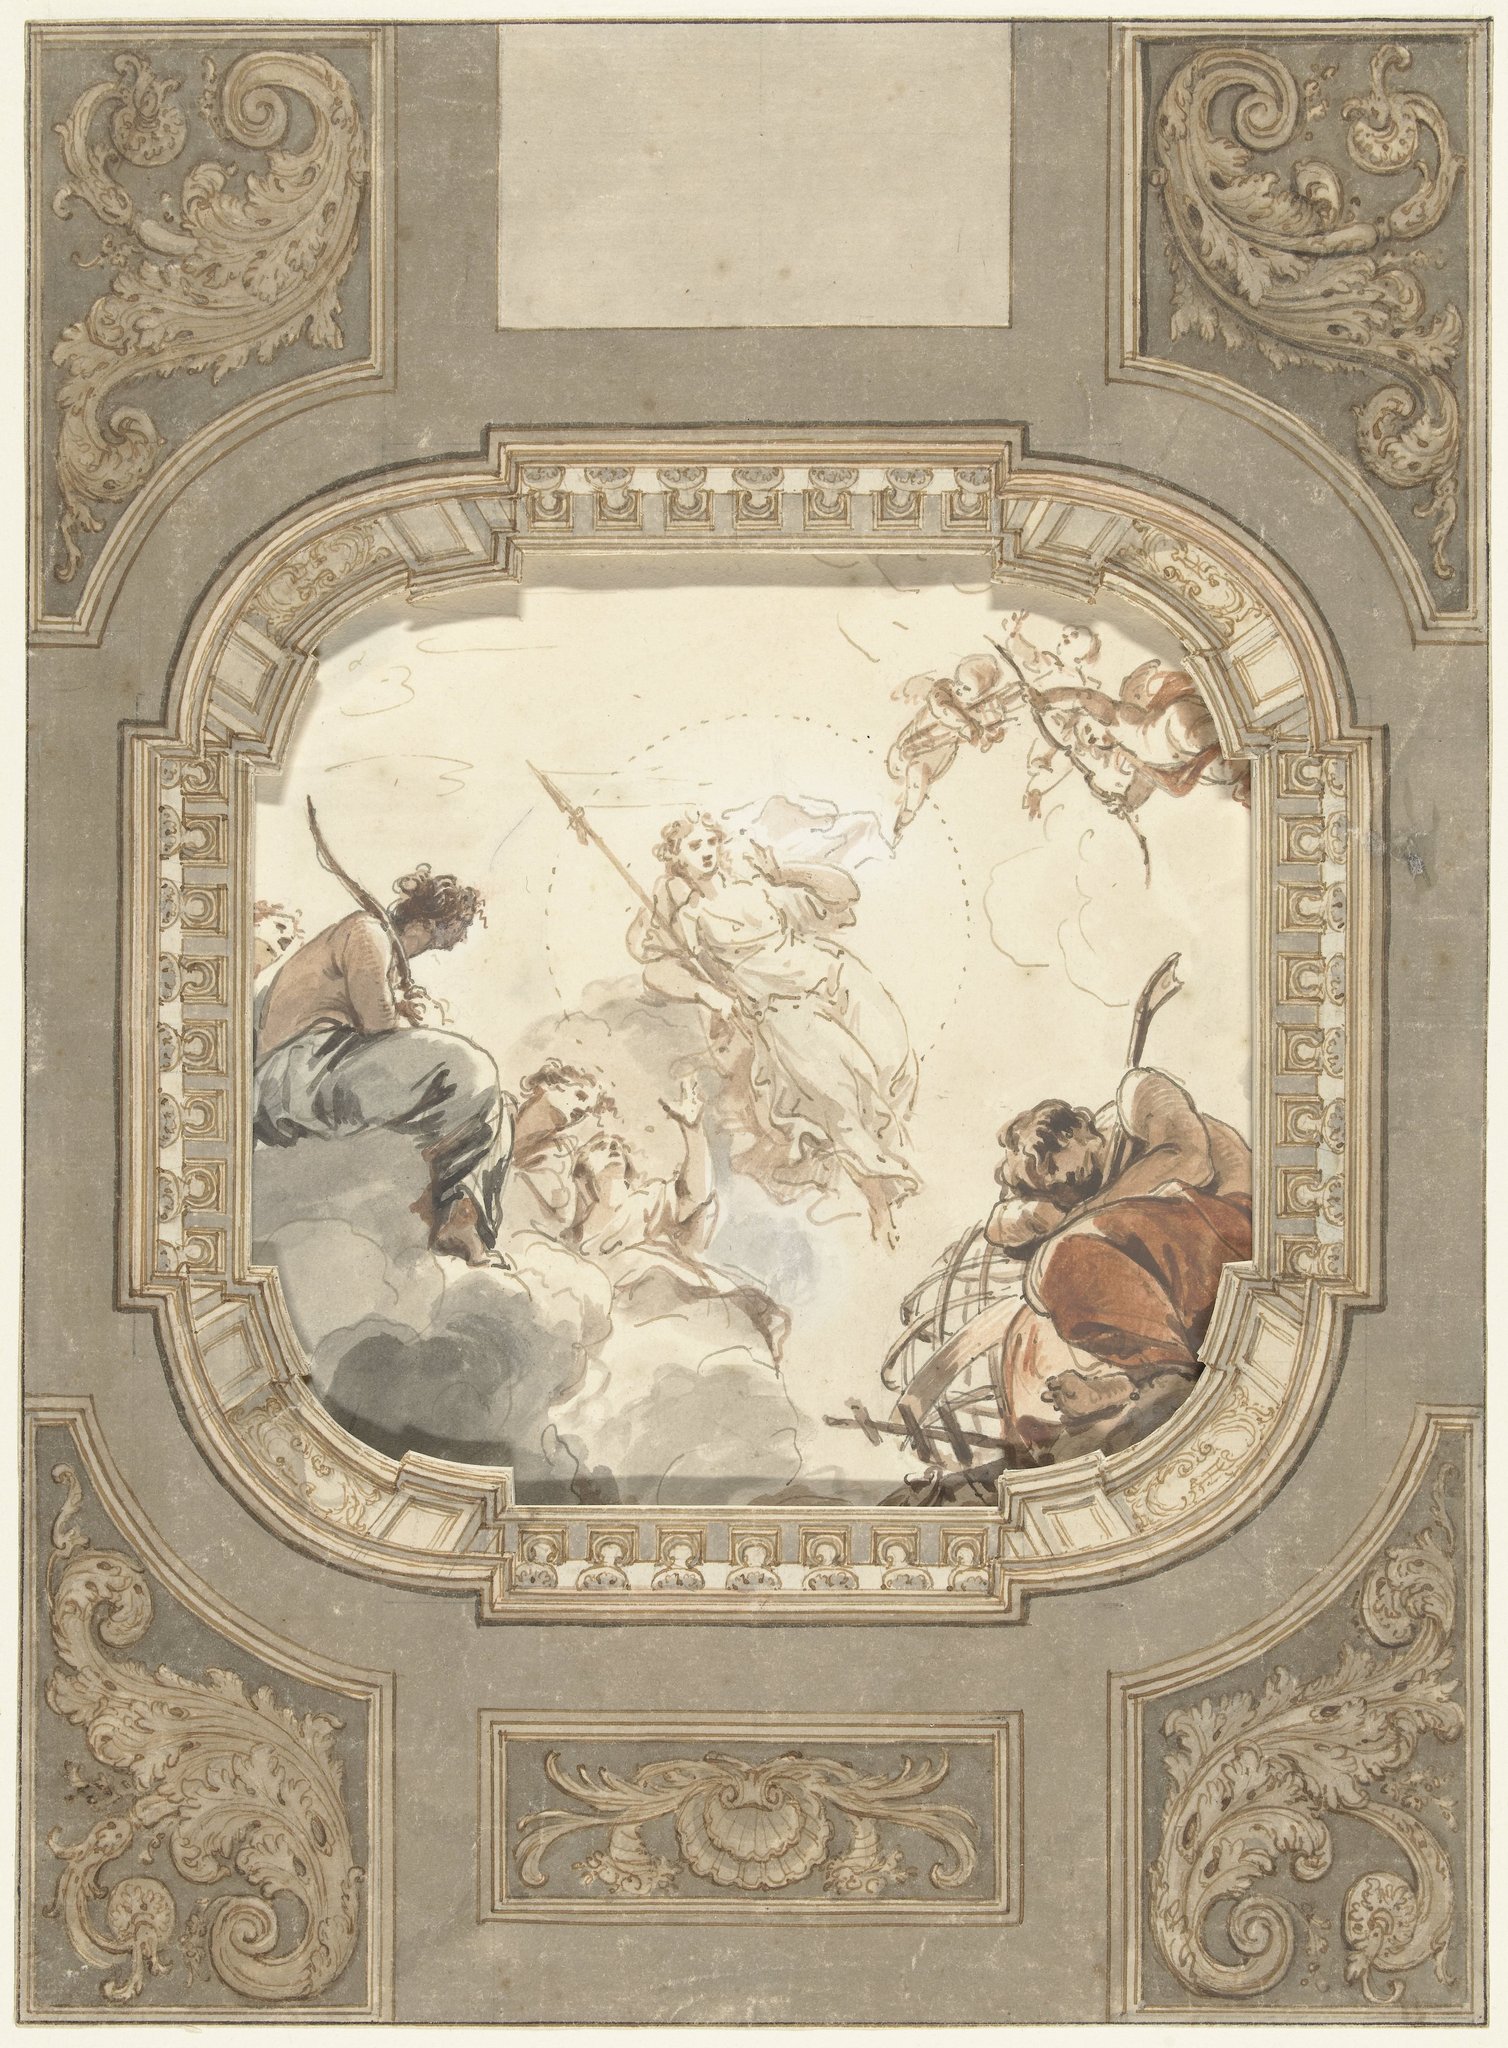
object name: drawing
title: Ontwerp voor een architecturaal kader rond een plafondschildering van Jacob de Wit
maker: isaac de moucheron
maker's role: draughtsman, painter, print maker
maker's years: 1667-1744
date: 1726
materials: ink, paper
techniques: brush, pen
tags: ornaments ~ art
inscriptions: inscription: ‘t zaeltjen van Moucheron / Hemzelf & De Wit Linksonder’, inscription: ‘Afkomstig van Ploos van Amstel’, inscription: ‘Der Vereeniging Rembrandt aangeboden / 1884 met stempel A. Verhuell’